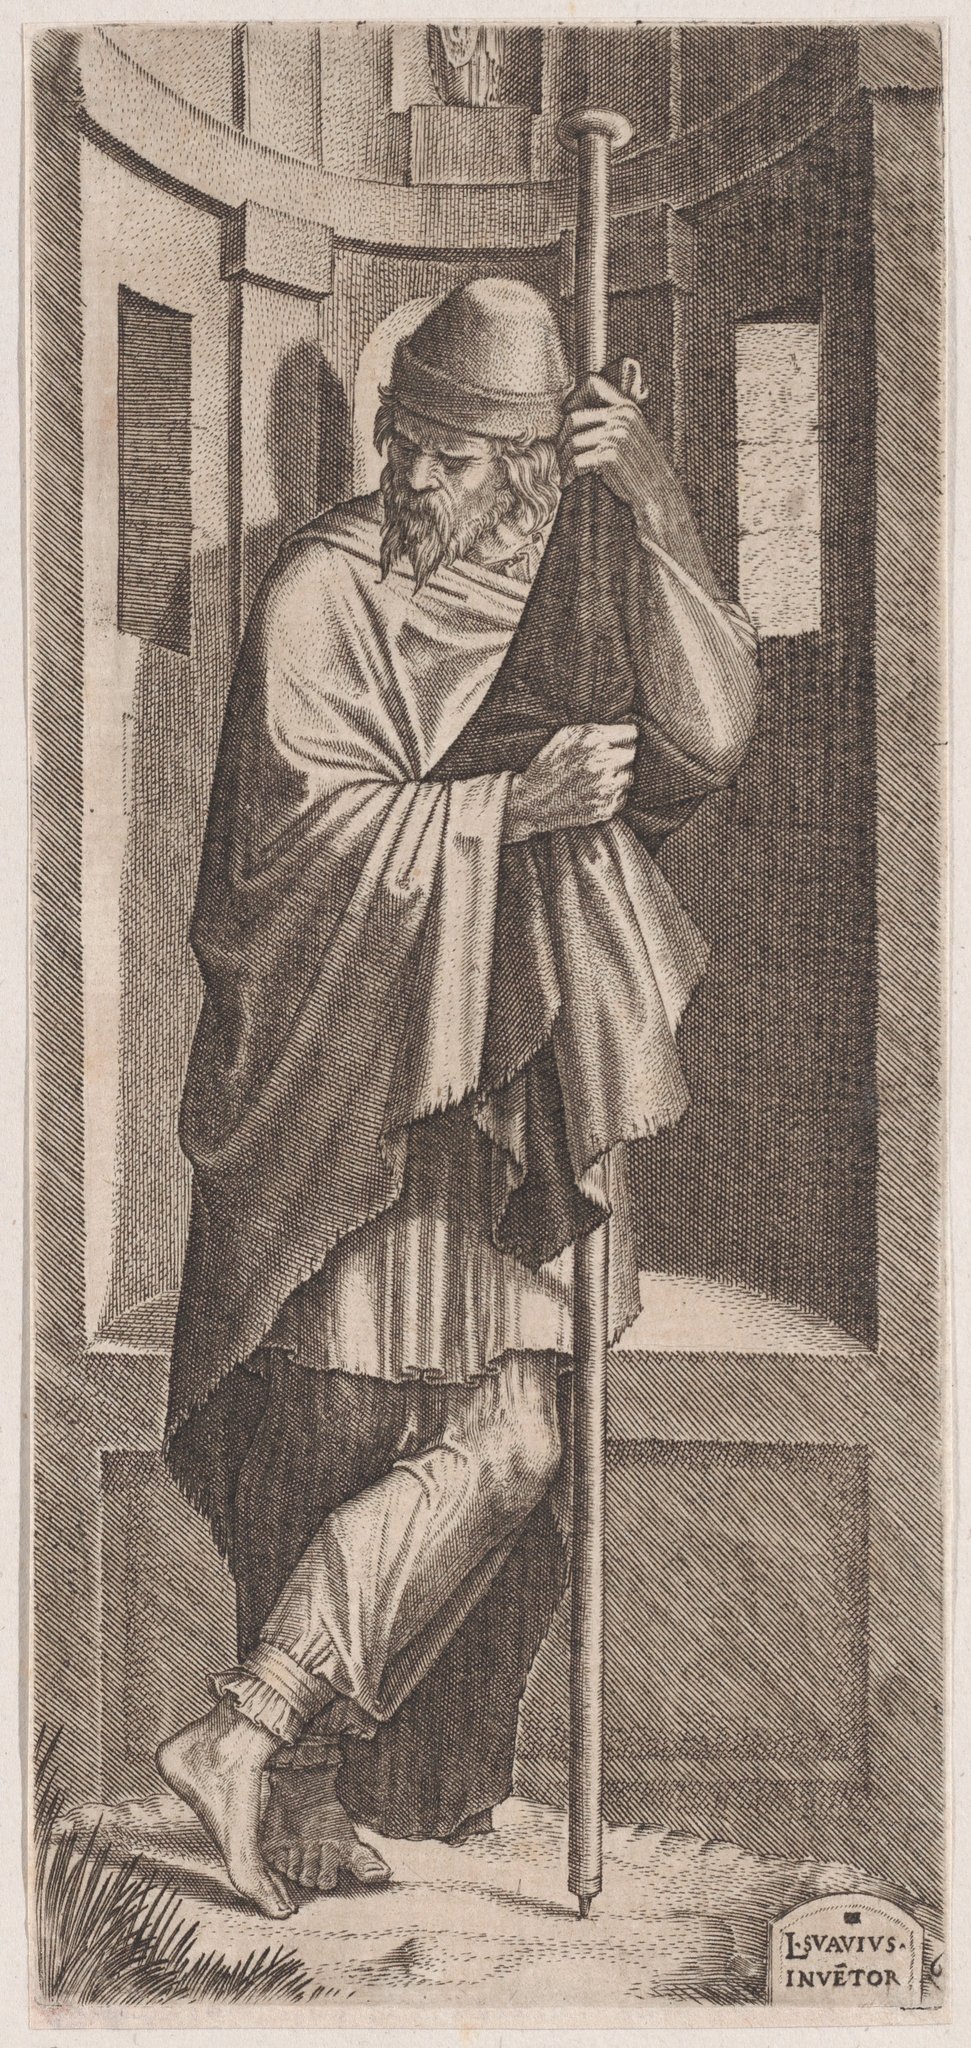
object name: print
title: St. James Major, from "Christ, the Twelve Apostles and St. Paul"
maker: lambert suavius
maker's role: artist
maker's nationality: netherlandish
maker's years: 1510-1576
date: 1525-1576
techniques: engraving